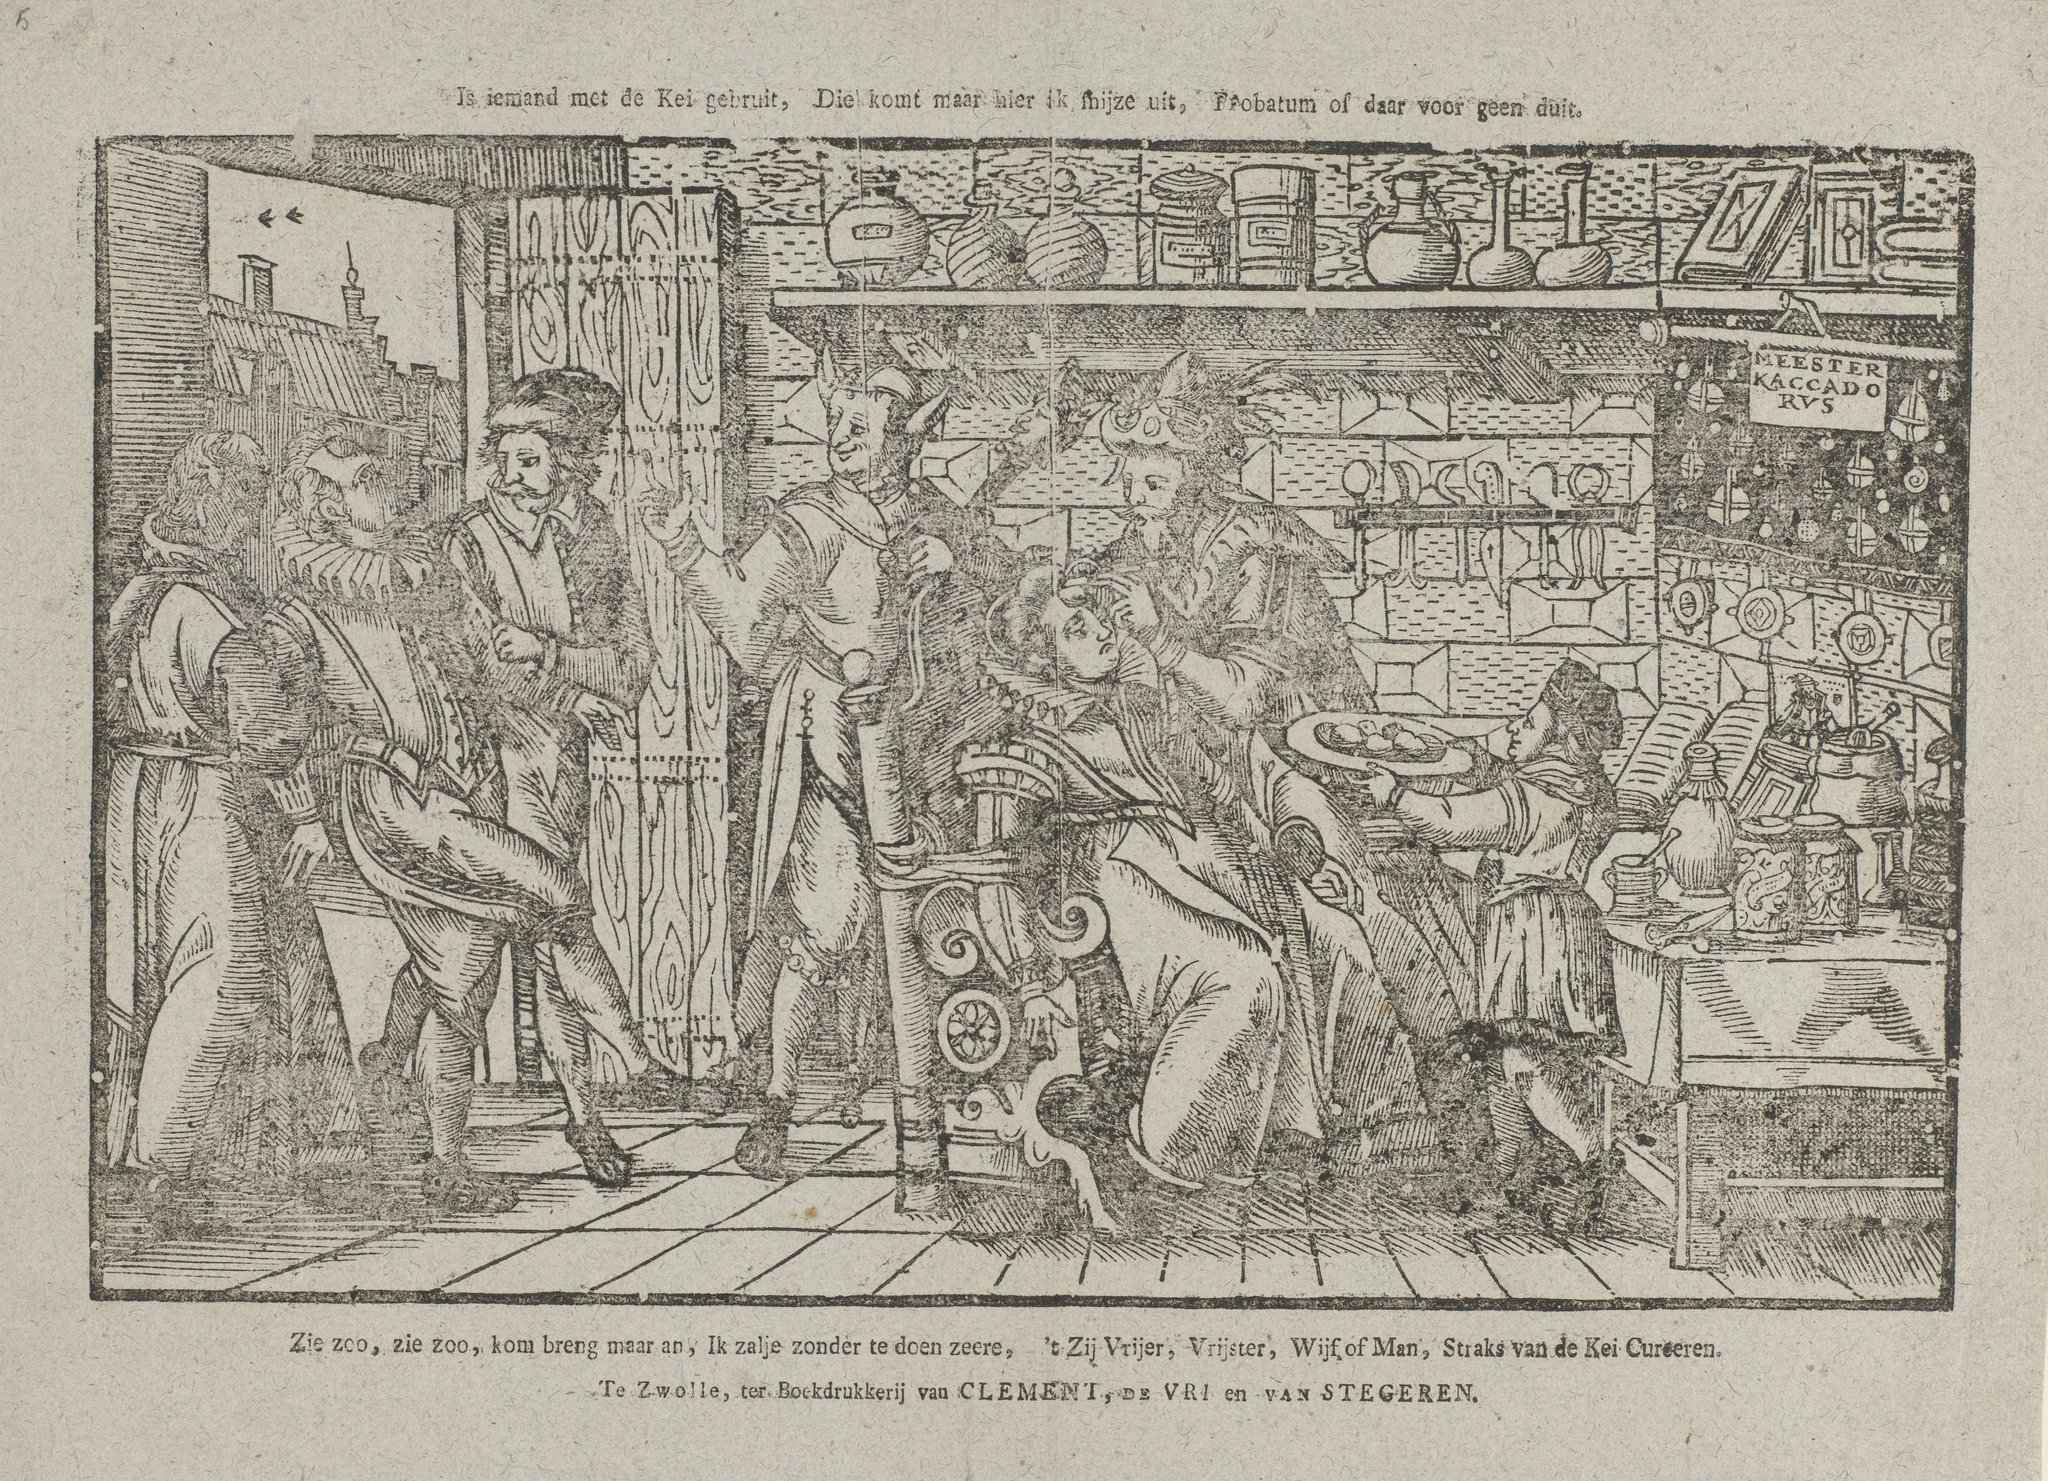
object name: print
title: Is iemand met de kei gebruit, Die komt maar hier ik snijze uit, Probatum of daarvoor geen duit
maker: Anonymous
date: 1816-1836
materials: paper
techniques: letterpress printing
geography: zwolle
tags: quack, charlatan, mountebank, 'saltimbanco', stone-operation, e.g.: by the witch of malleghem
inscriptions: collector's mark: Lugt 2760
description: De keisnijder geneest een vrouw van domheid door een kei uit haar voorhoofd te snijden. Links door de deur wordt een man met een kei in zijn voorhoofd naar binnen gebracht. Onder de voorstelling een versregel.